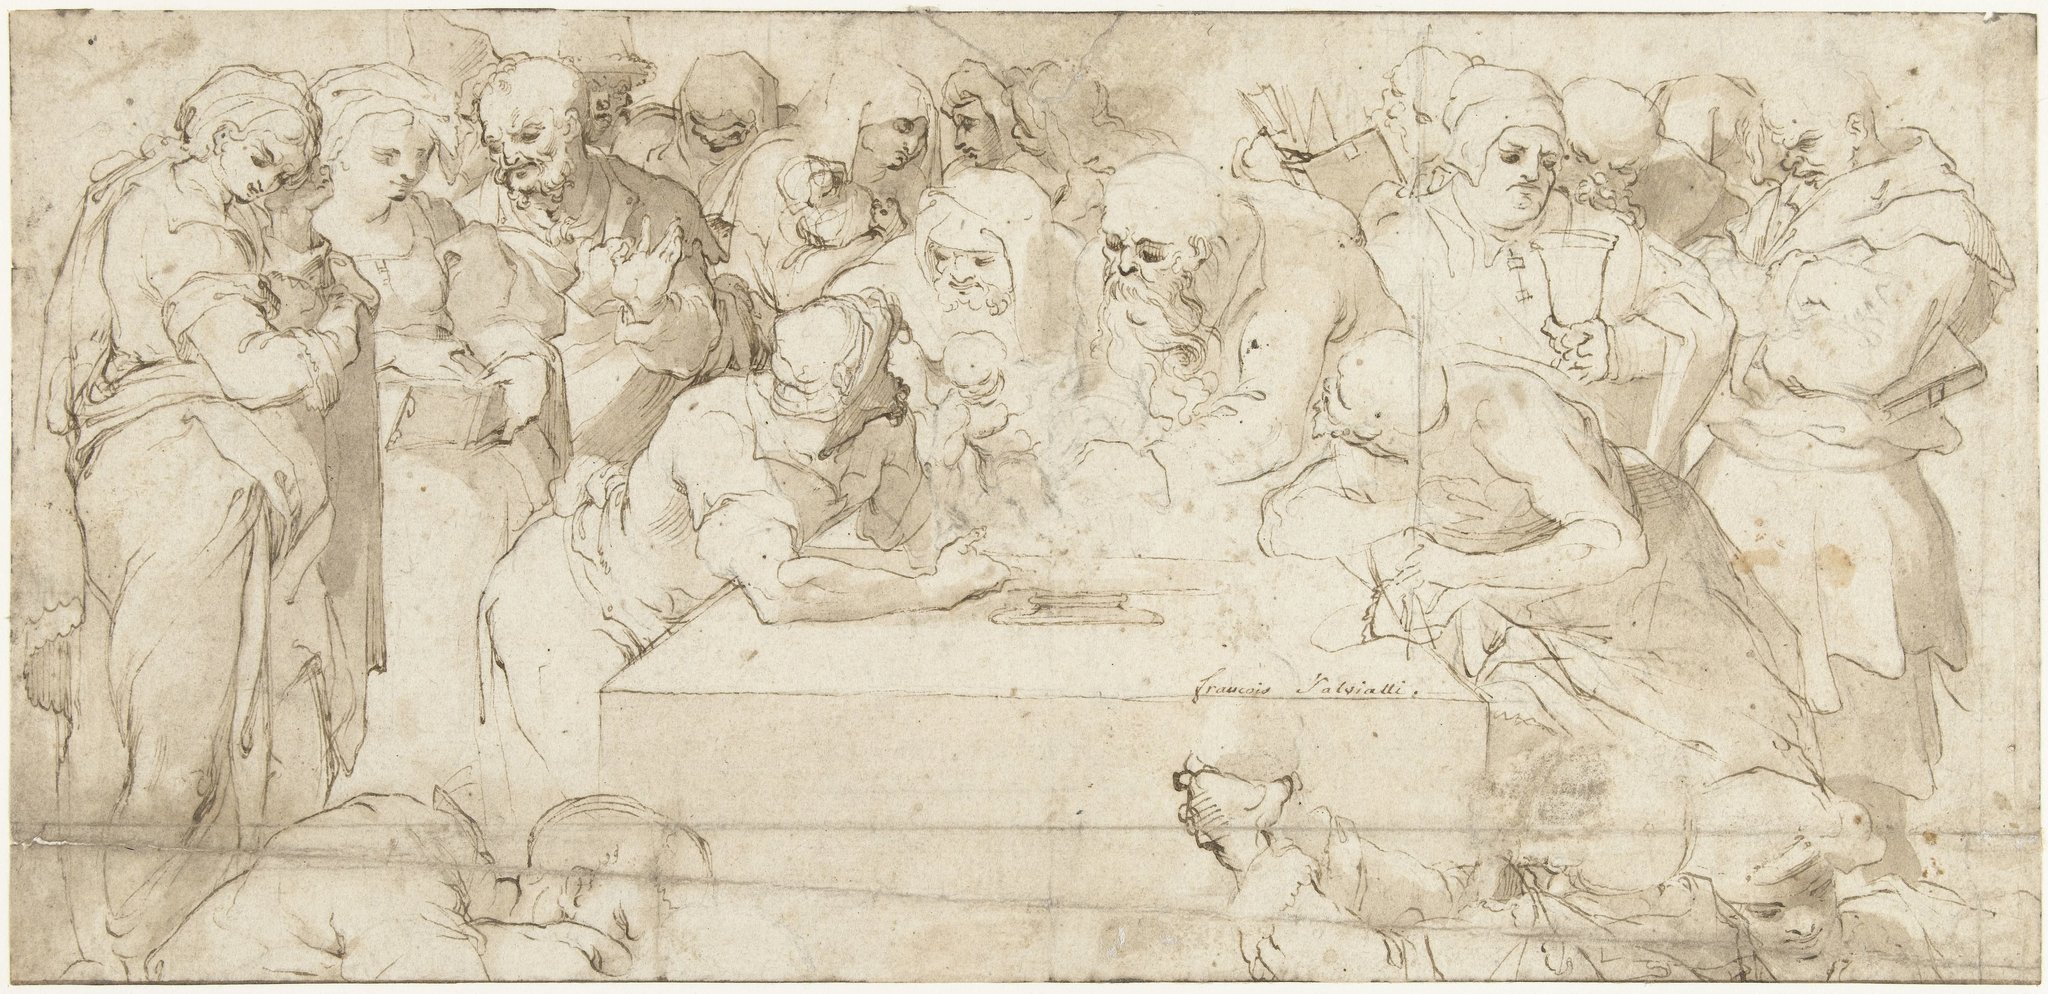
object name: drawing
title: De besnijdenis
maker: giovanni francesco bezzi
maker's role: draughtsman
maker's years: 1500-1571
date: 1550-1571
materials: chalk, ink, paper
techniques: brush, pen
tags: circumcision of the christ-child by the priest in the temple (luke 2:21)